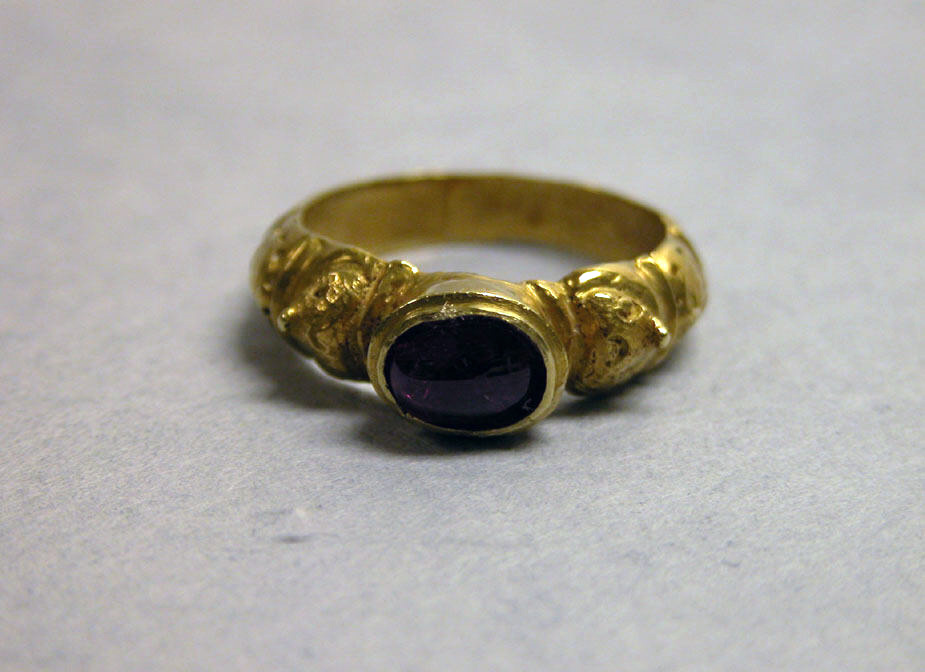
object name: ring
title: Ring with Red Stone set in Unadorned Bezel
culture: indonesian, javanese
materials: gold, stone